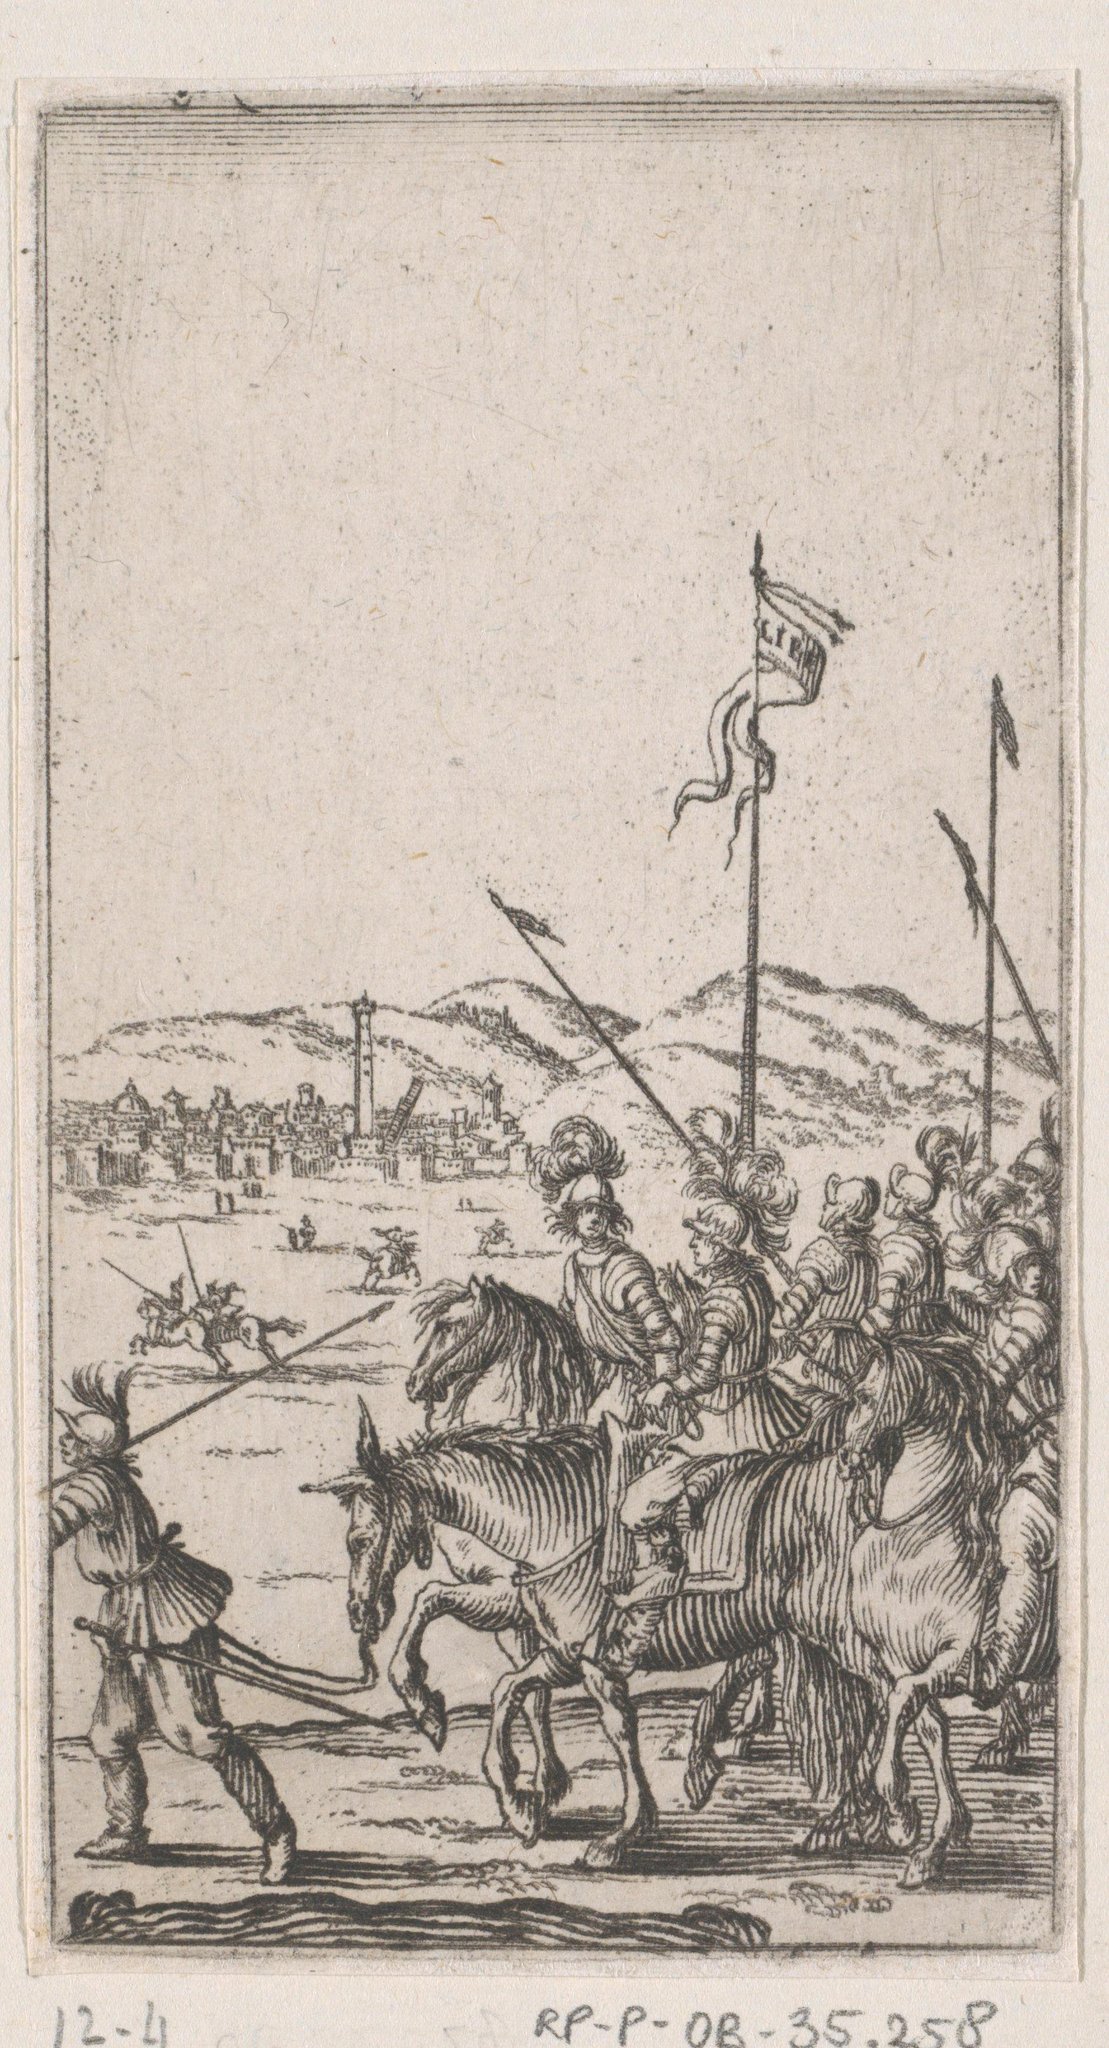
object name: print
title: Optrekkende soldaten te paard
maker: Anonymous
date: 1620-1664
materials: paper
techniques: etching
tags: city-view, and landscape with man-made constructions, warfare; military affairs (+ cavalry, horsemen), the soldier; the soldier's life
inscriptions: collector's mark: Lugt 240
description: Op de voorgrond een groep optrekkende soldaten te paard. Op de achtergrond een gezicht op een stad tussen de heuvels.